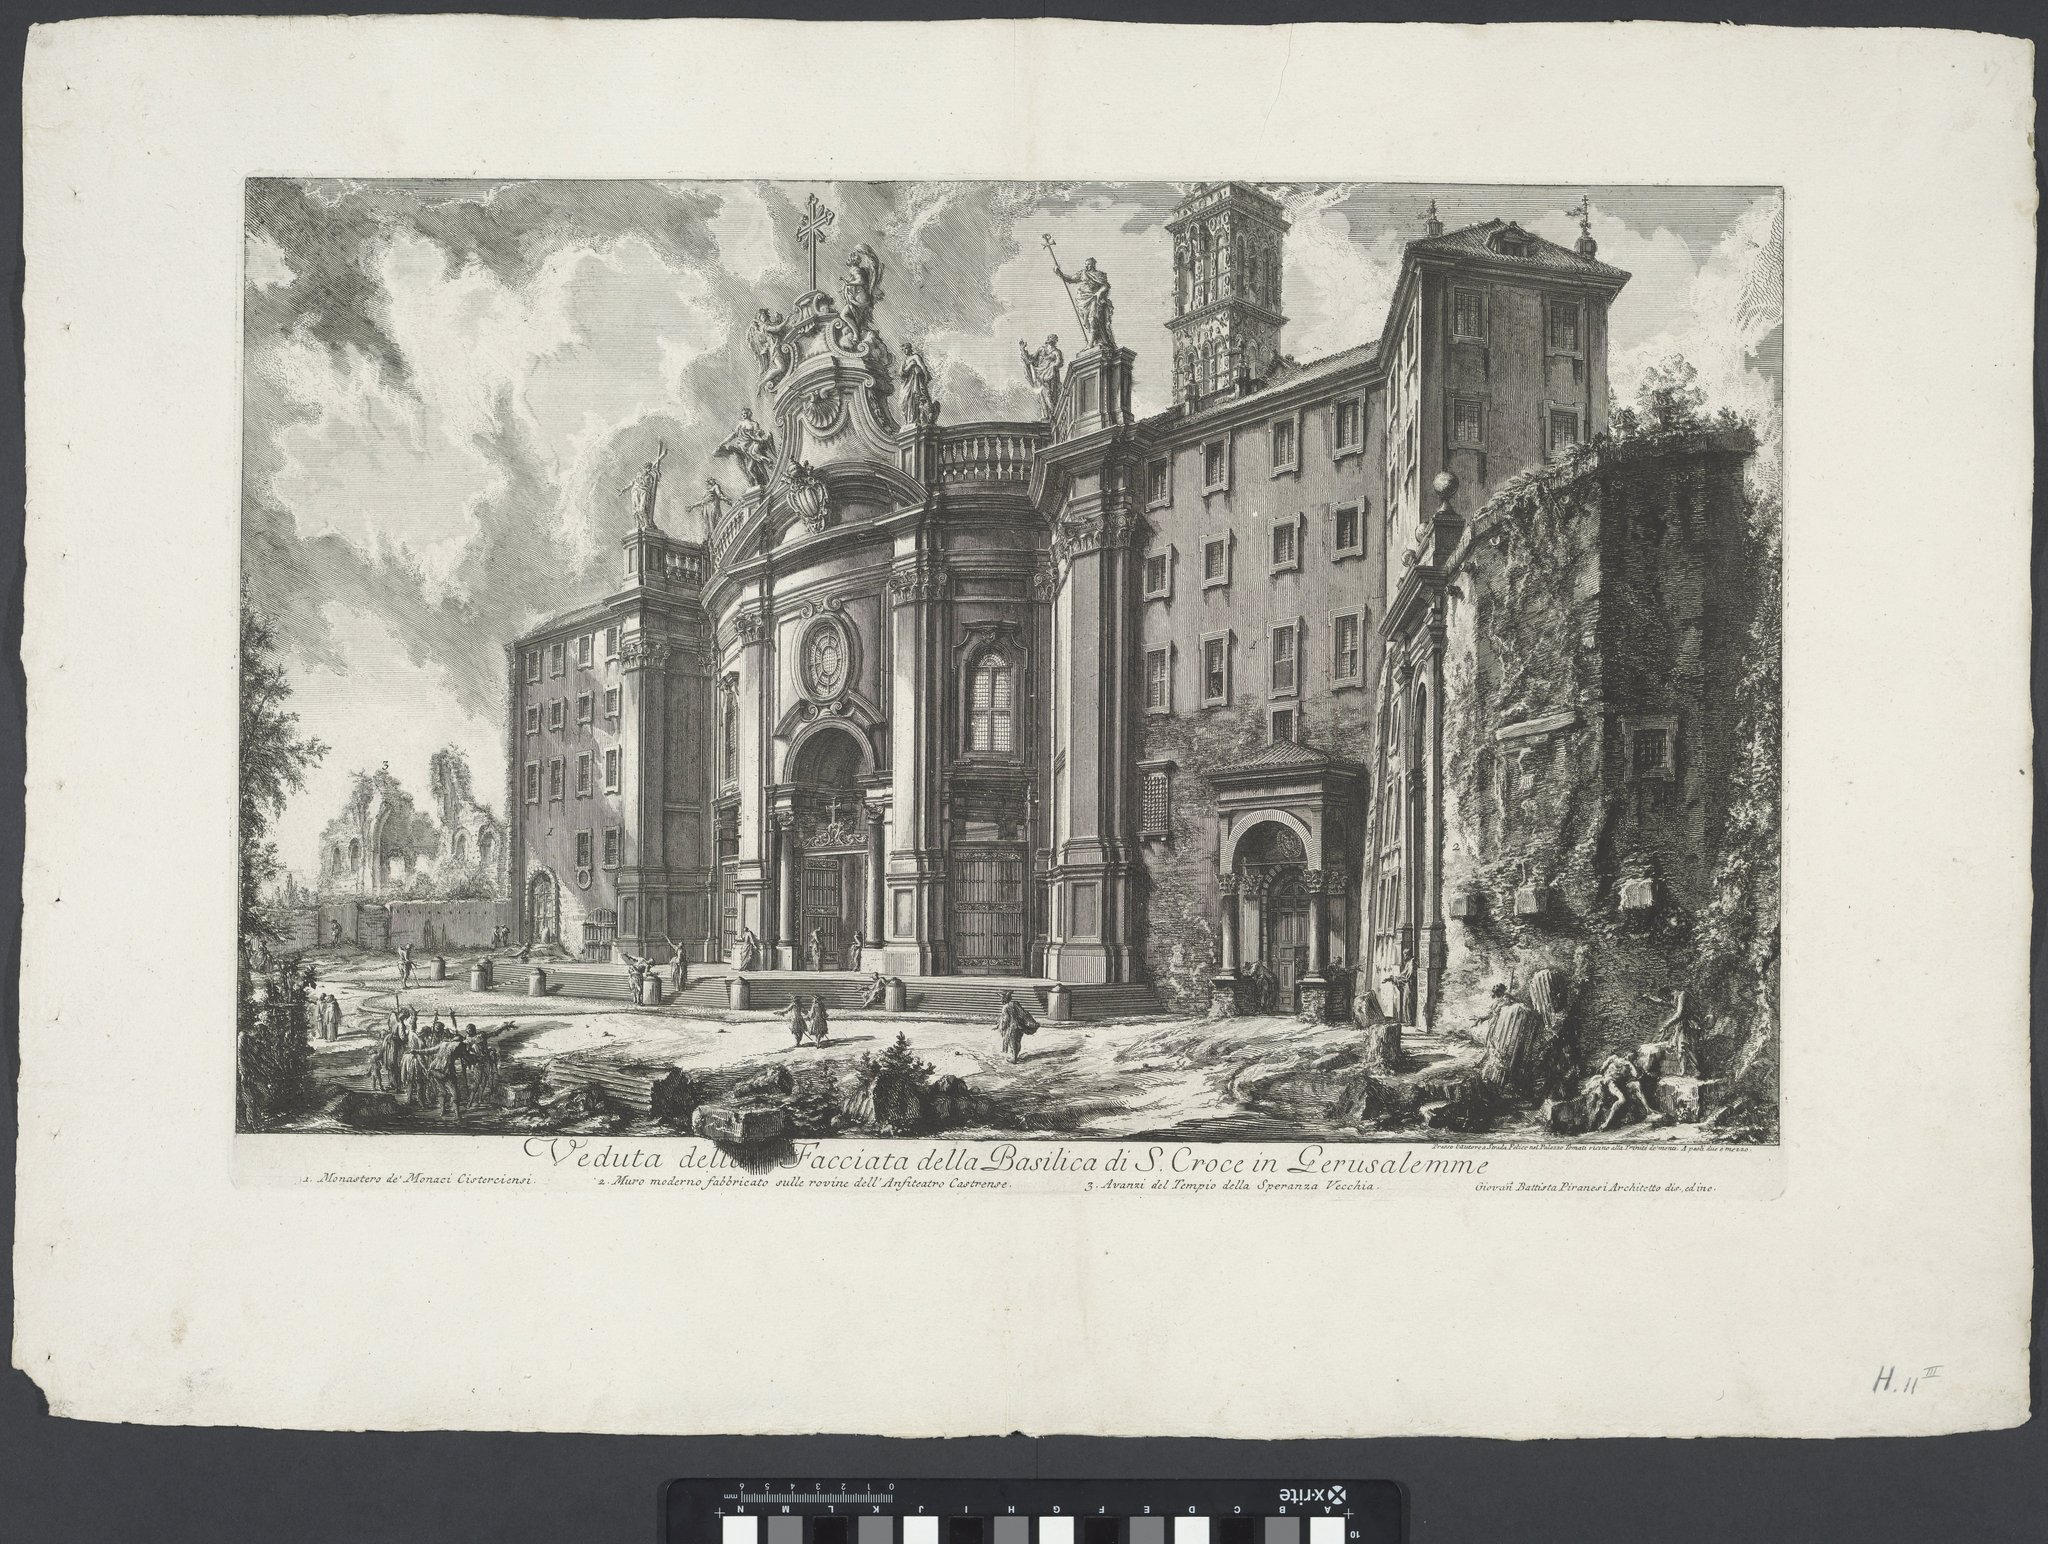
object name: print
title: Gezichten op Rome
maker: giovanni battista piranesi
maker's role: designer, draughtsman, print maker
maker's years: 1720-1778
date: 1748-1778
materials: paper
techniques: etching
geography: rome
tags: church (exterior), roman catholic church, rome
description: Deze prent maakt deel uit van de serie 'Vedute di Roma'. Piranesi werkte aan deze 135 platen tellende serie tussen 1748 en zijn dood in 1778. Francesco Piranesi voegde later nog twee prenten toe aan de reeks van zijn vader.